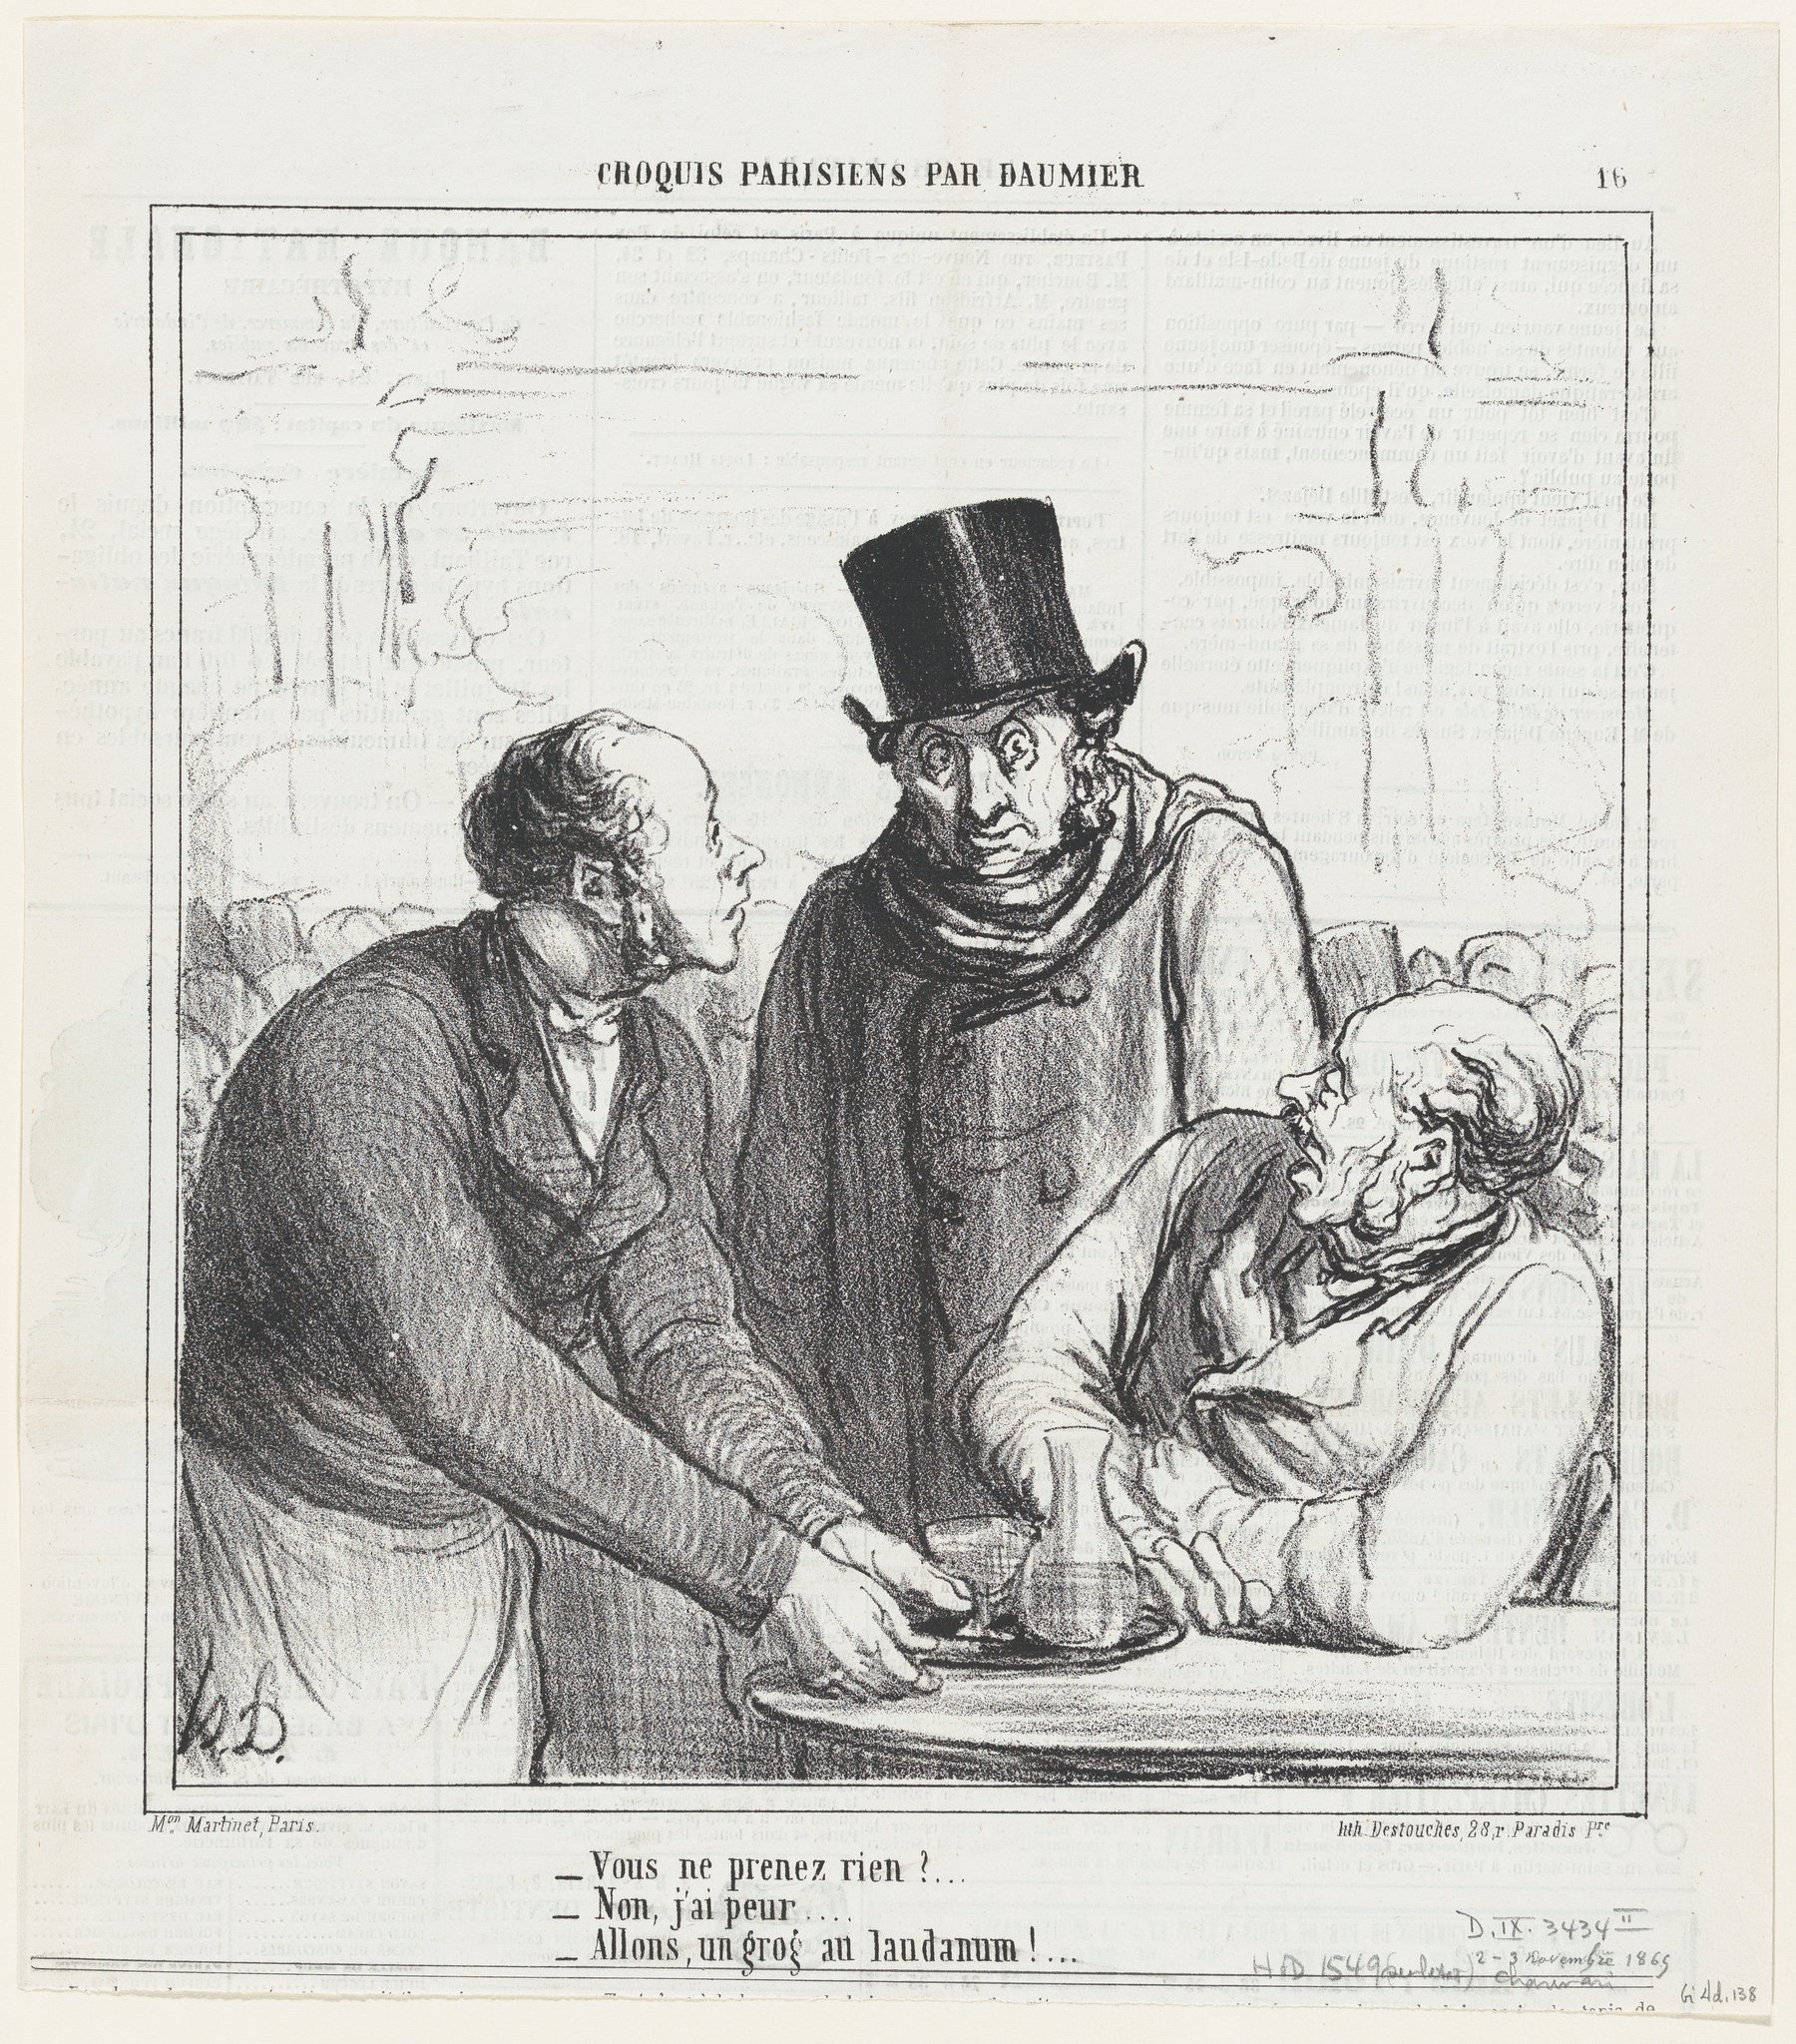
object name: print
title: You're not having anything?, from 'Parisian sketches,' published in Le Charivari, November 2-3, 1865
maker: honoré daumier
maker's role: artist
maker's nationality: french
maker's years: 1808-1879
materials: paper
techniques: lithograph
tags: men